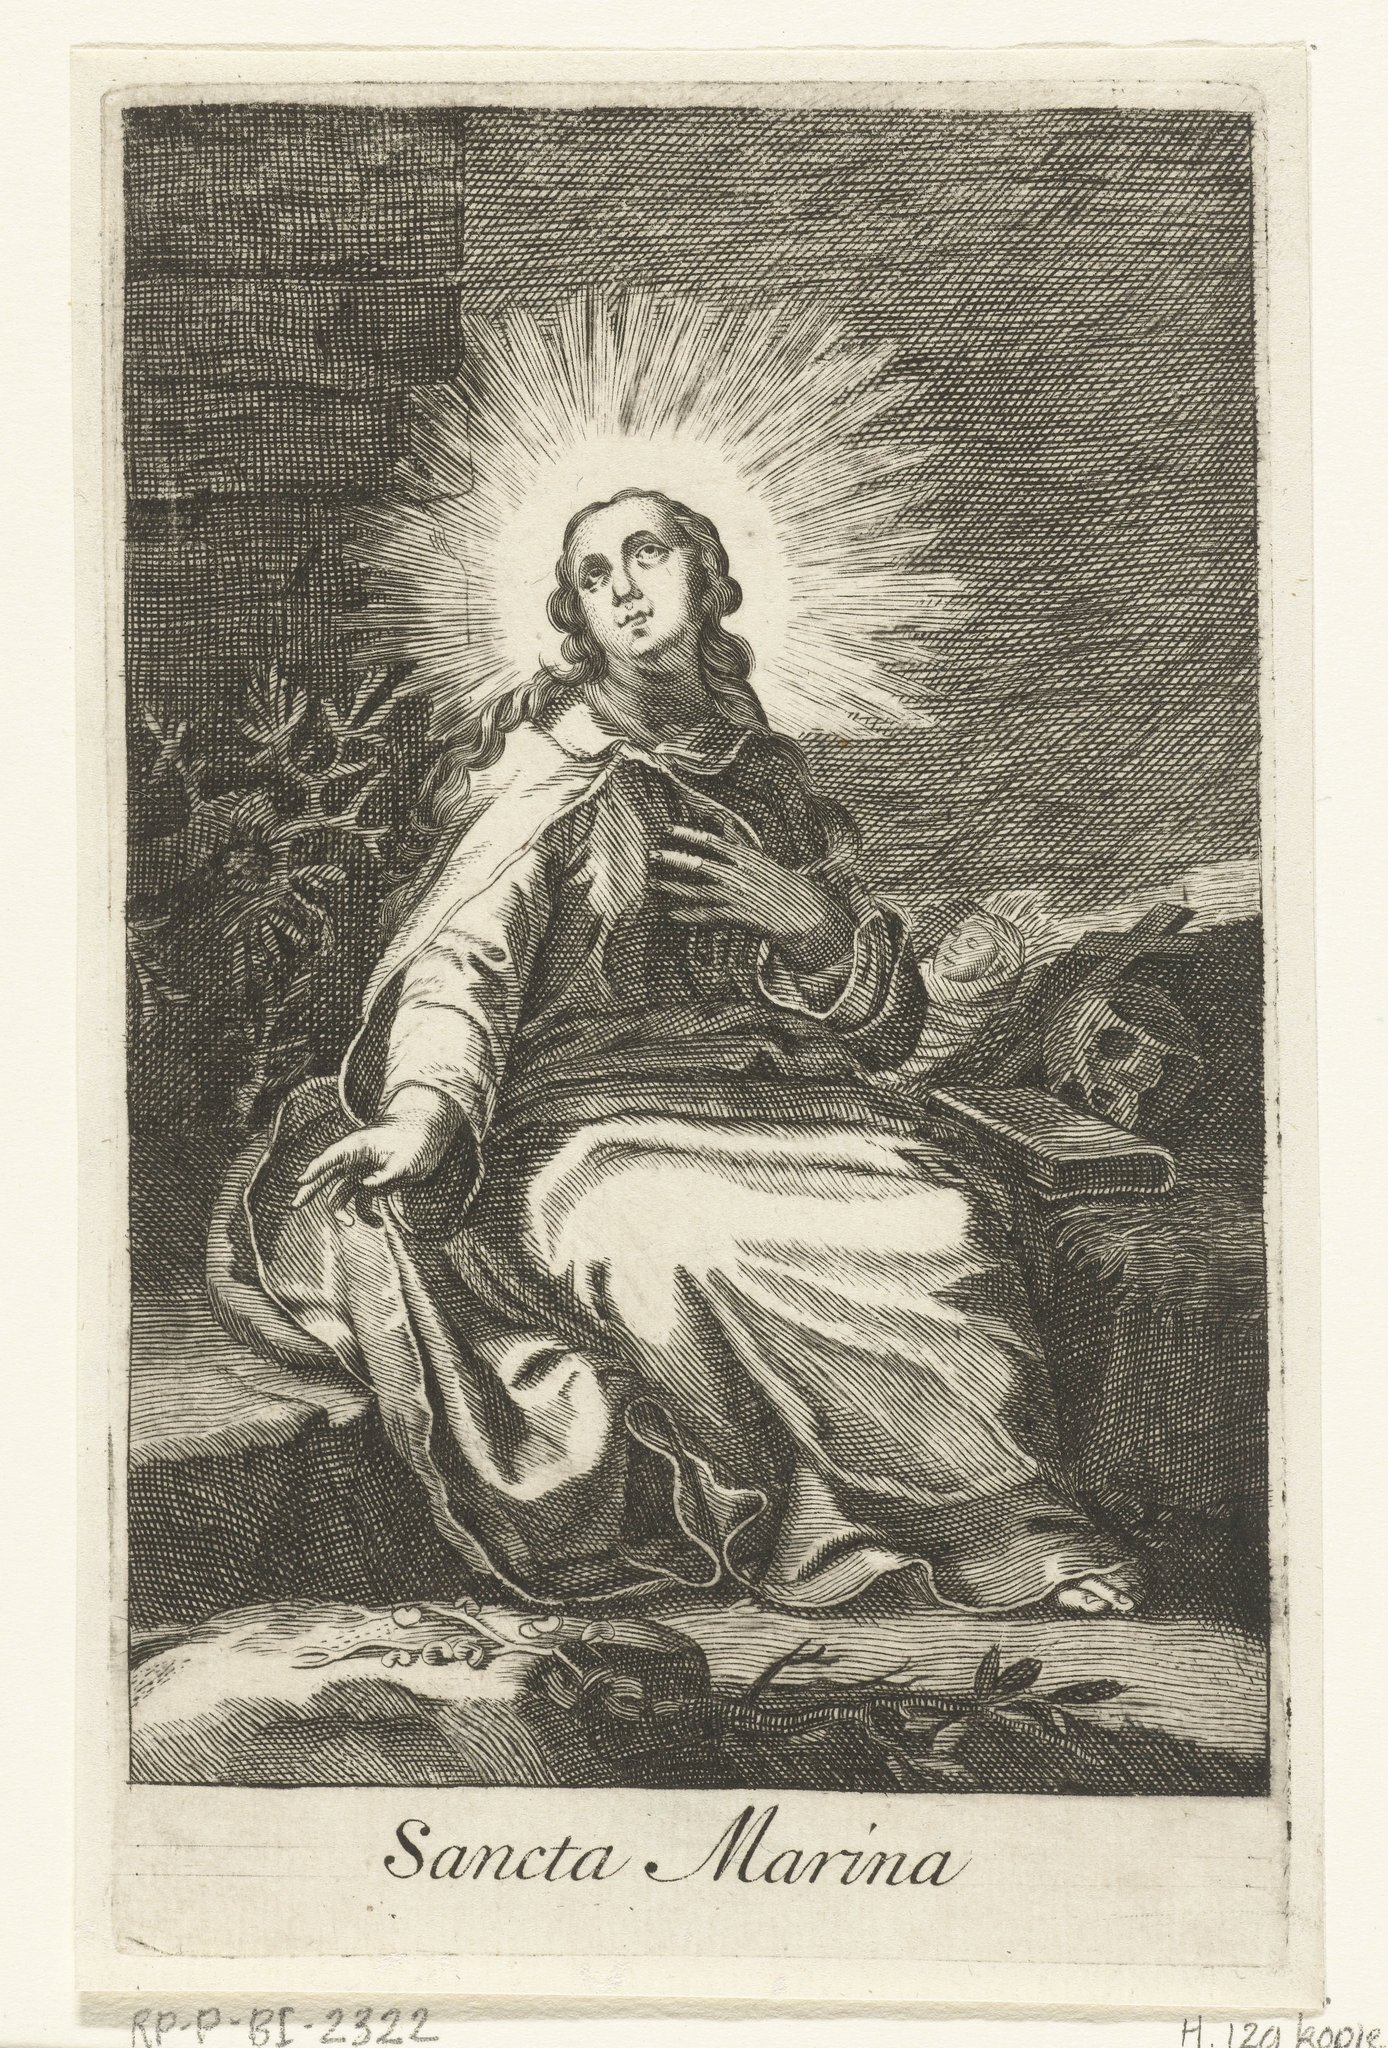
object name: print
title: Sancta Marina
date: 1590-1662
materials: paper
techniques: engraving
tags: anchorite, hermit, female saints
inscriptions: collector's mark: Lugt 2228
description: Kopie in spiegelbeeld naar prent van Boëtius Adamsz. Bolswert uit serie Kluizenaressen.